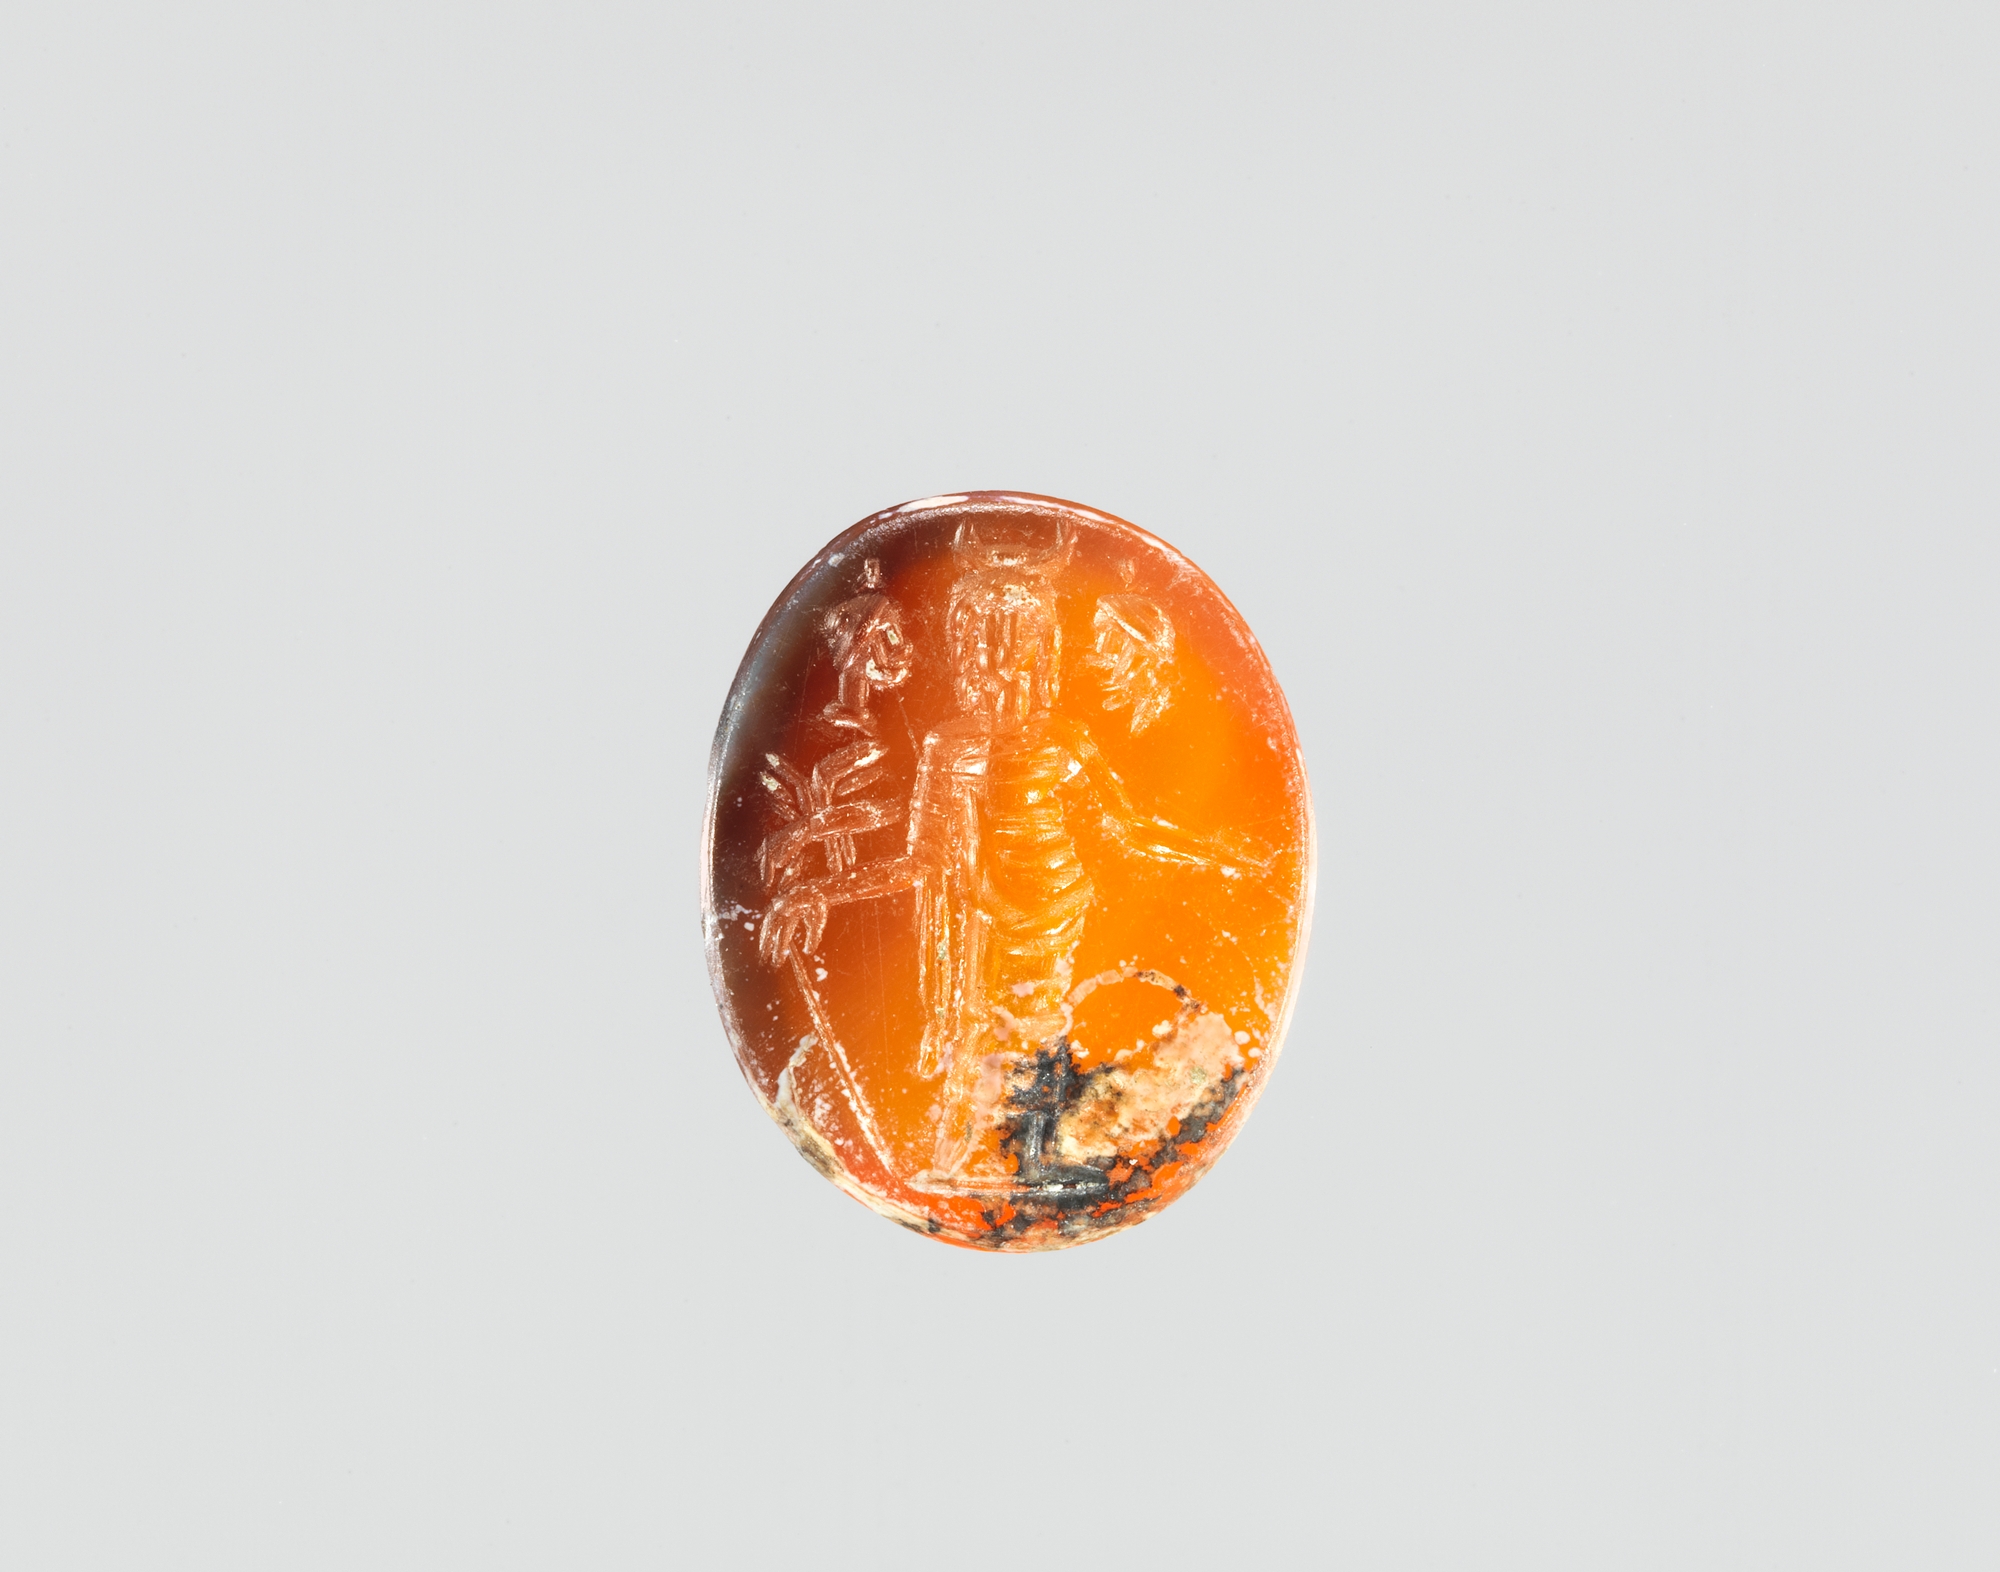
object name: intaglio, magical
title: Sard intaglio: Isis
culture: roman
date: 101-300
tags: isis